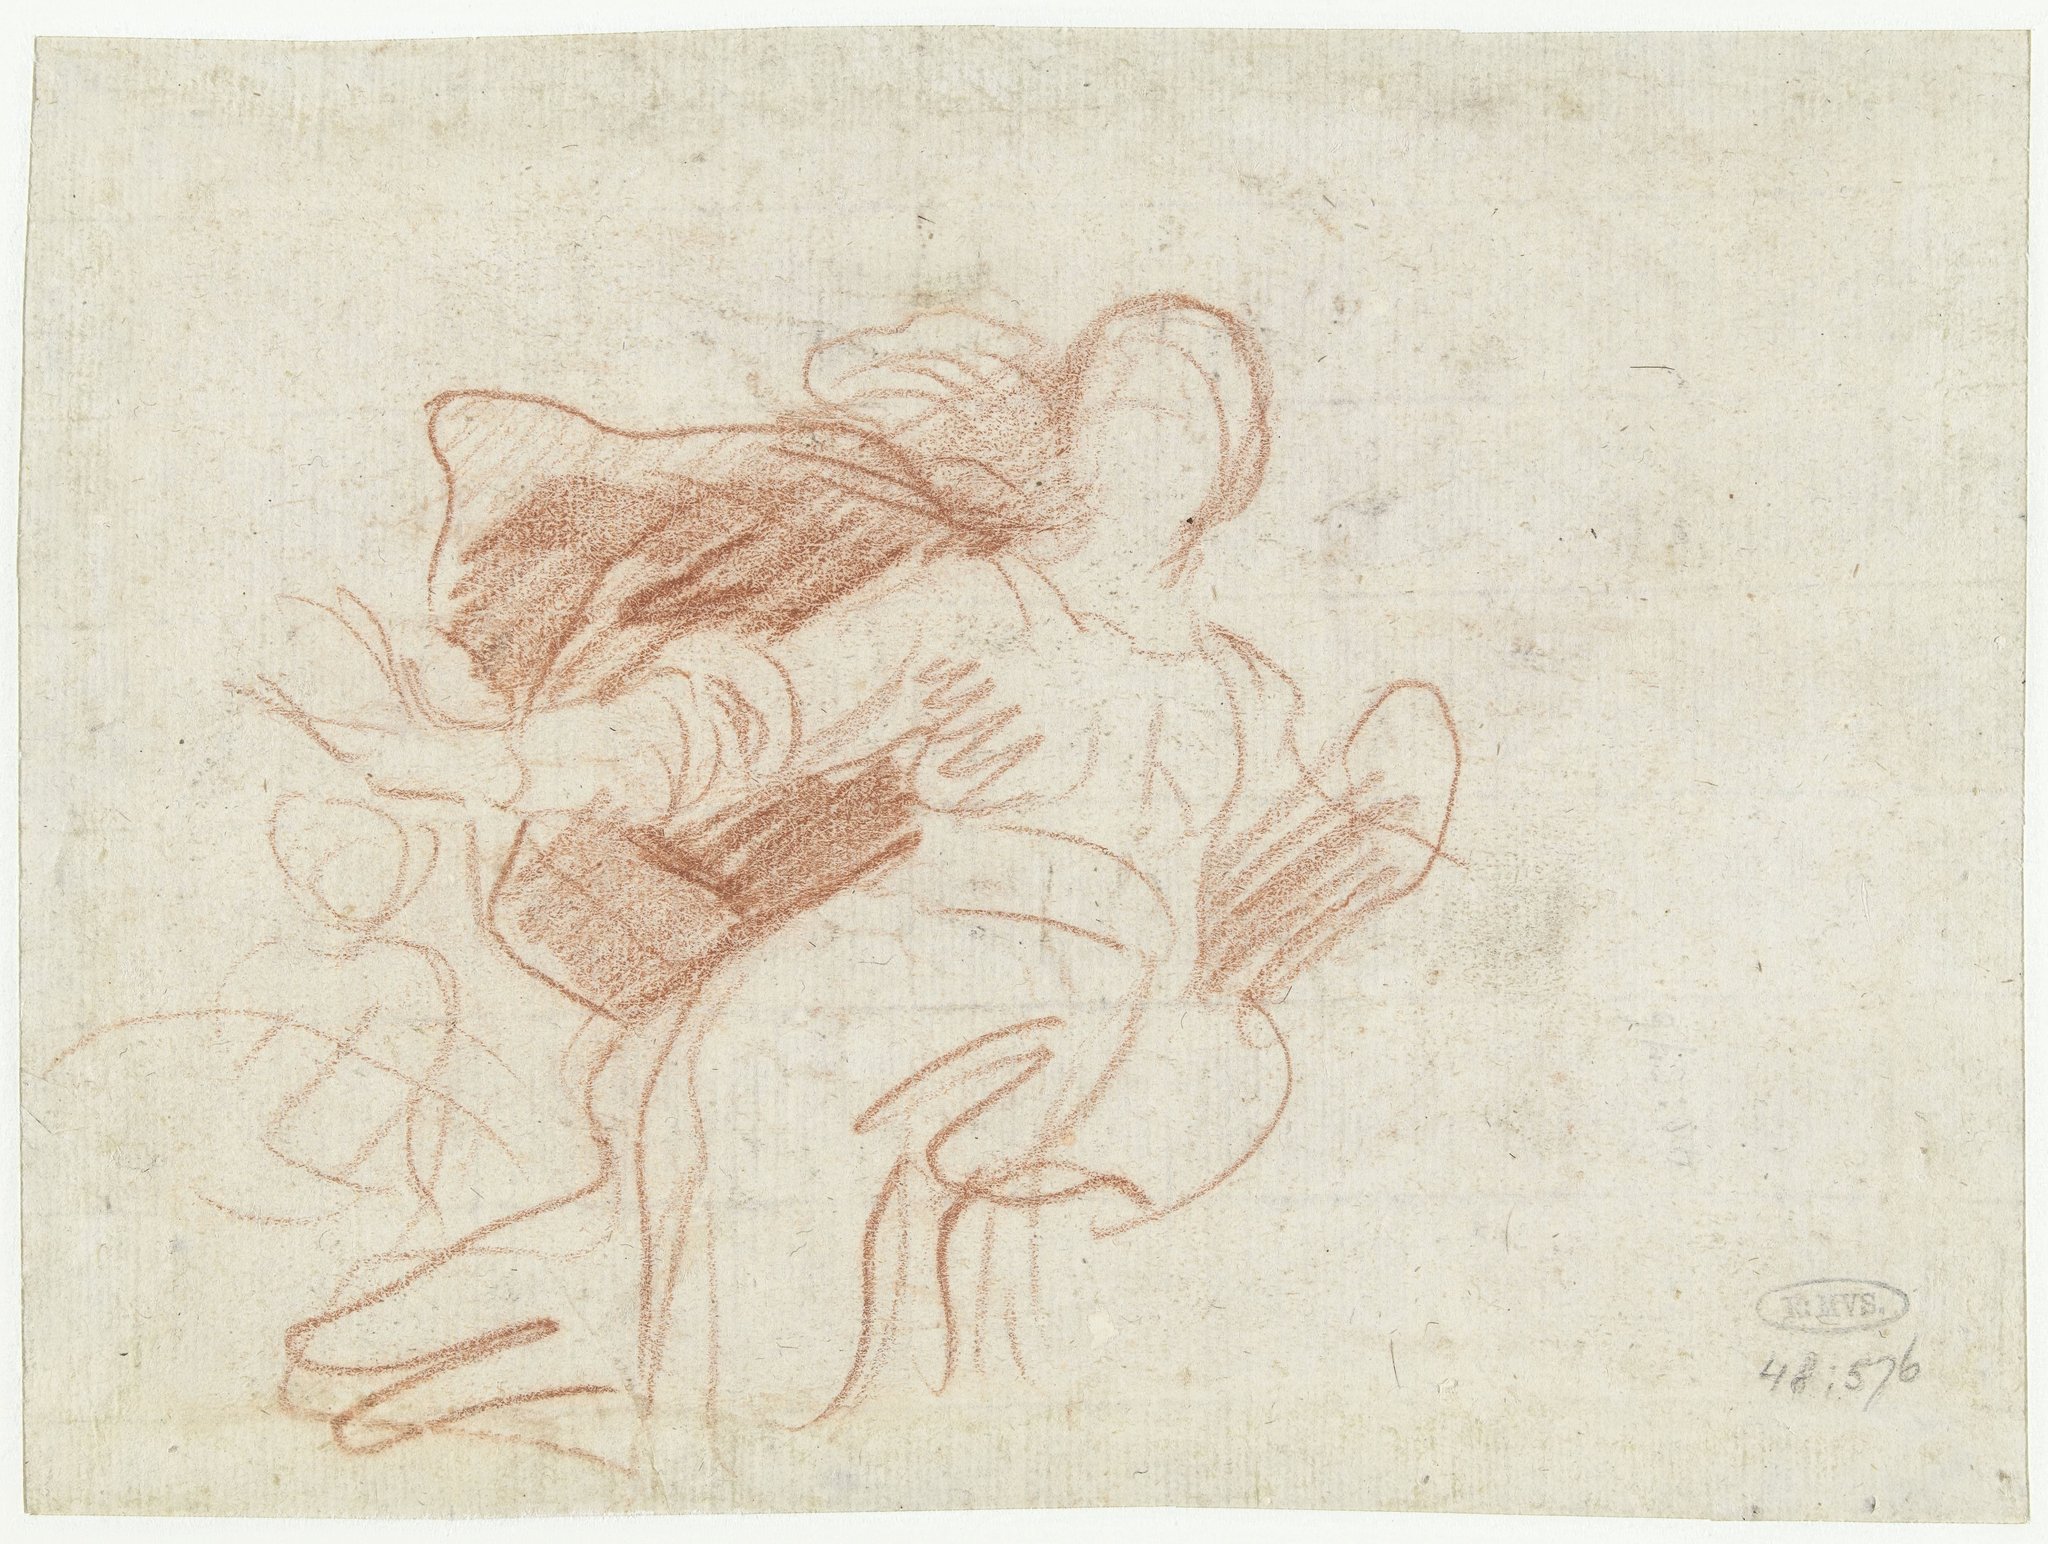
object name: drawing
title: Studie voor een zwevende vrouwenfiguur met een wijde mantel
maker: guglielmo cortese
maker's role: draughtsman, painter, print maker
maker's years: 1628-1679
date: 1664-1666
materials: chalk, paper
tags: female saints